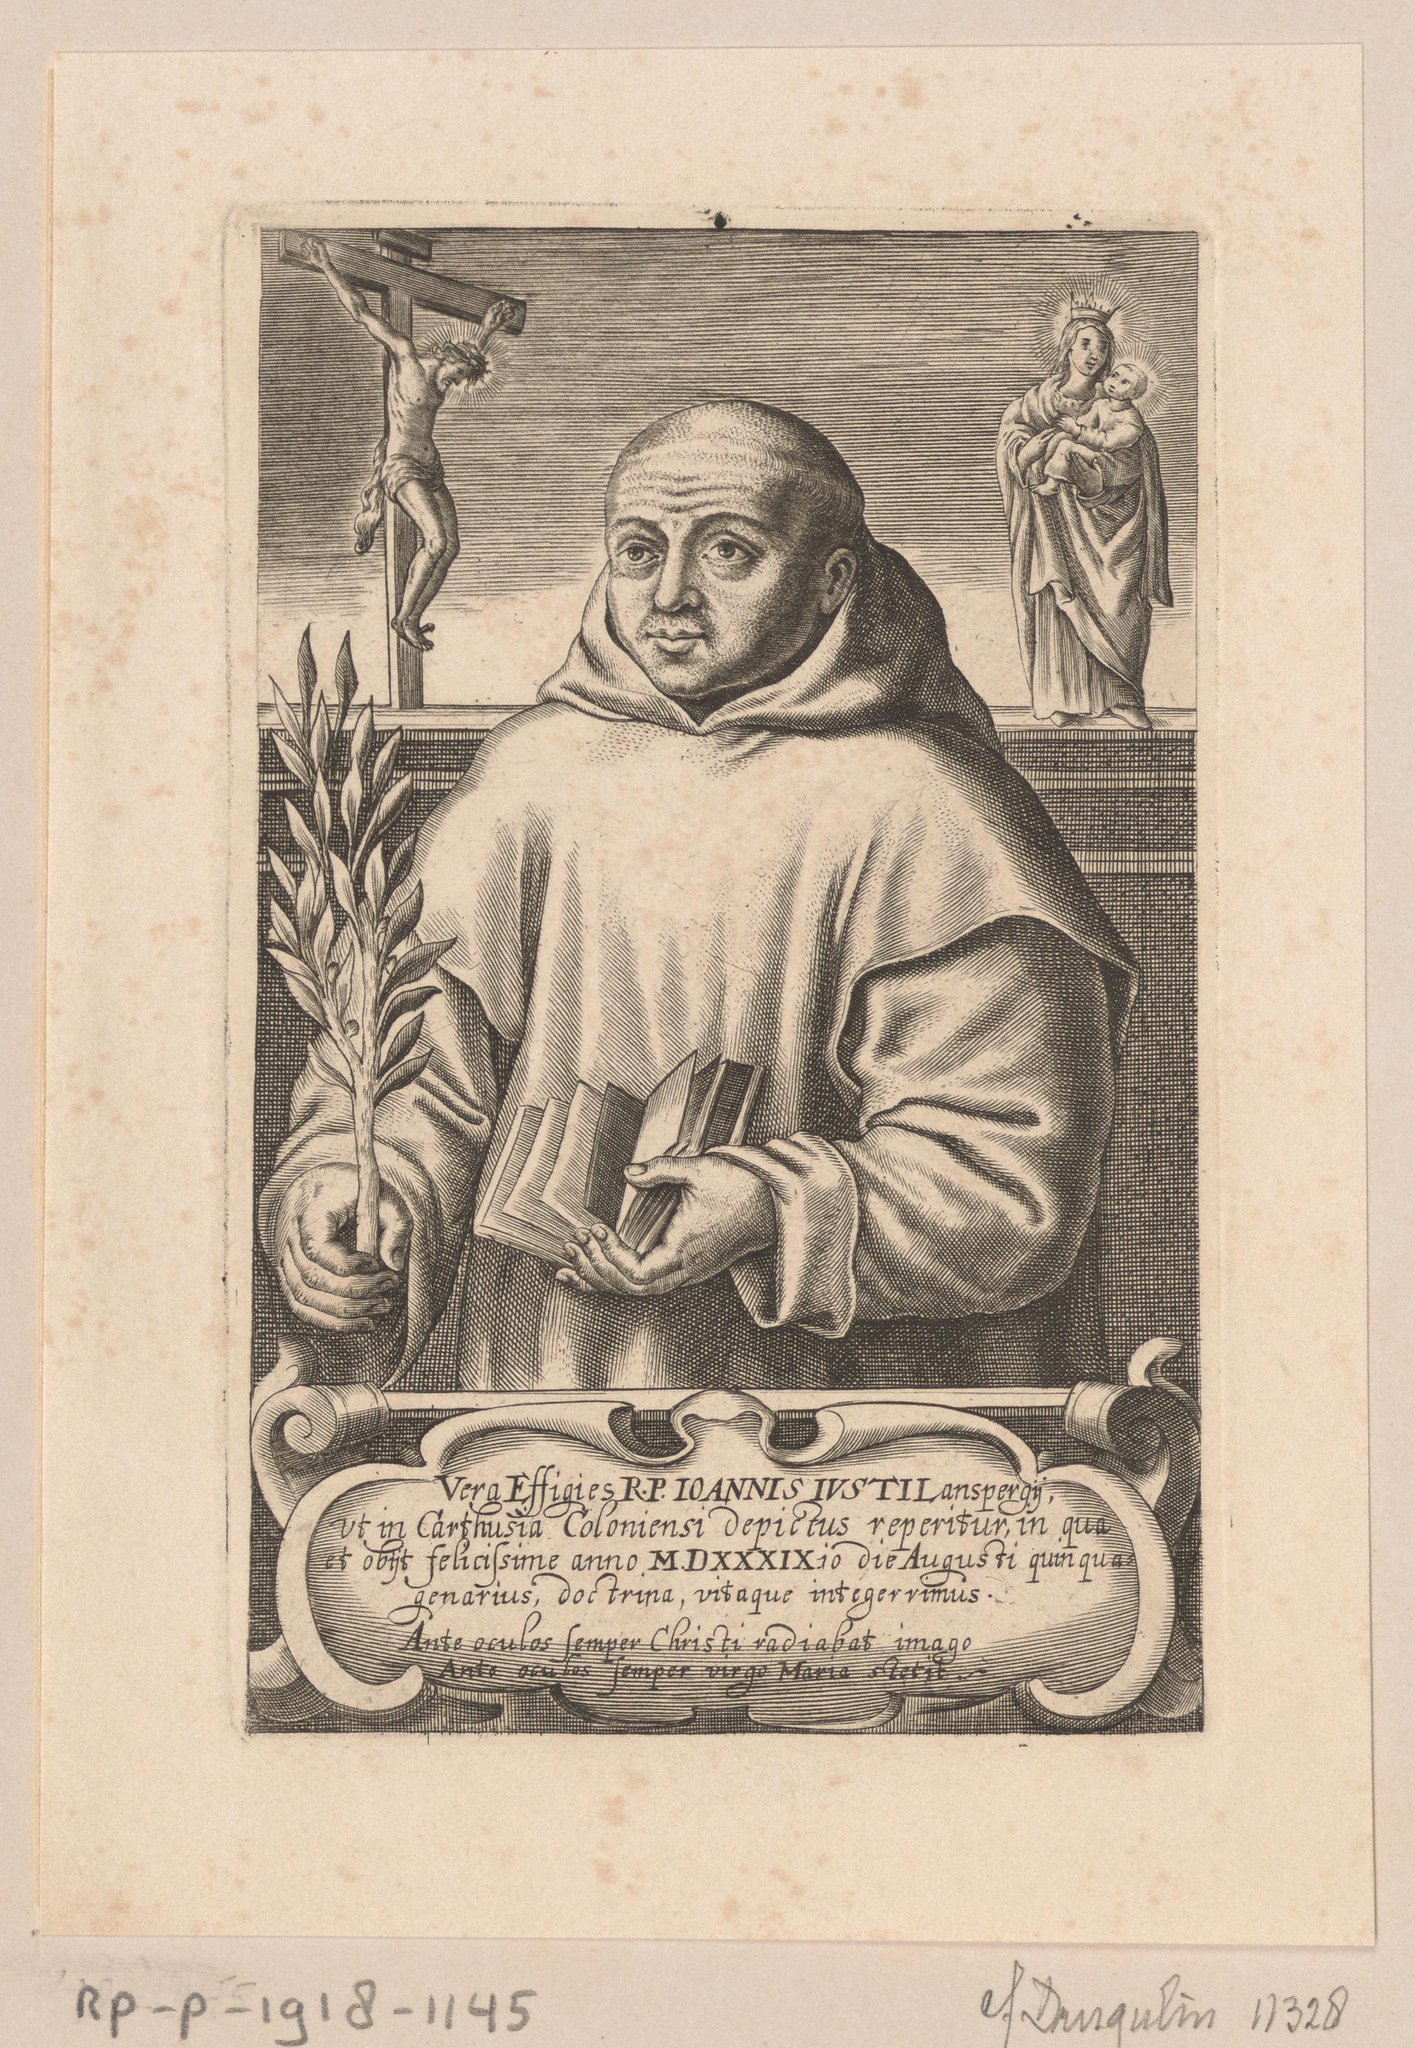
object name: print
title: Portret van Johannes Justus Landsberg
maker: Anonymous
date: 1600-1699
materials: paper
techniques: engraving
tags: altarcross, crucifix, historical persons, monk(s), friar(s), book - mm - book open, ornament ~ cartouche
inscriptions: collector's mark: Lugt 2233